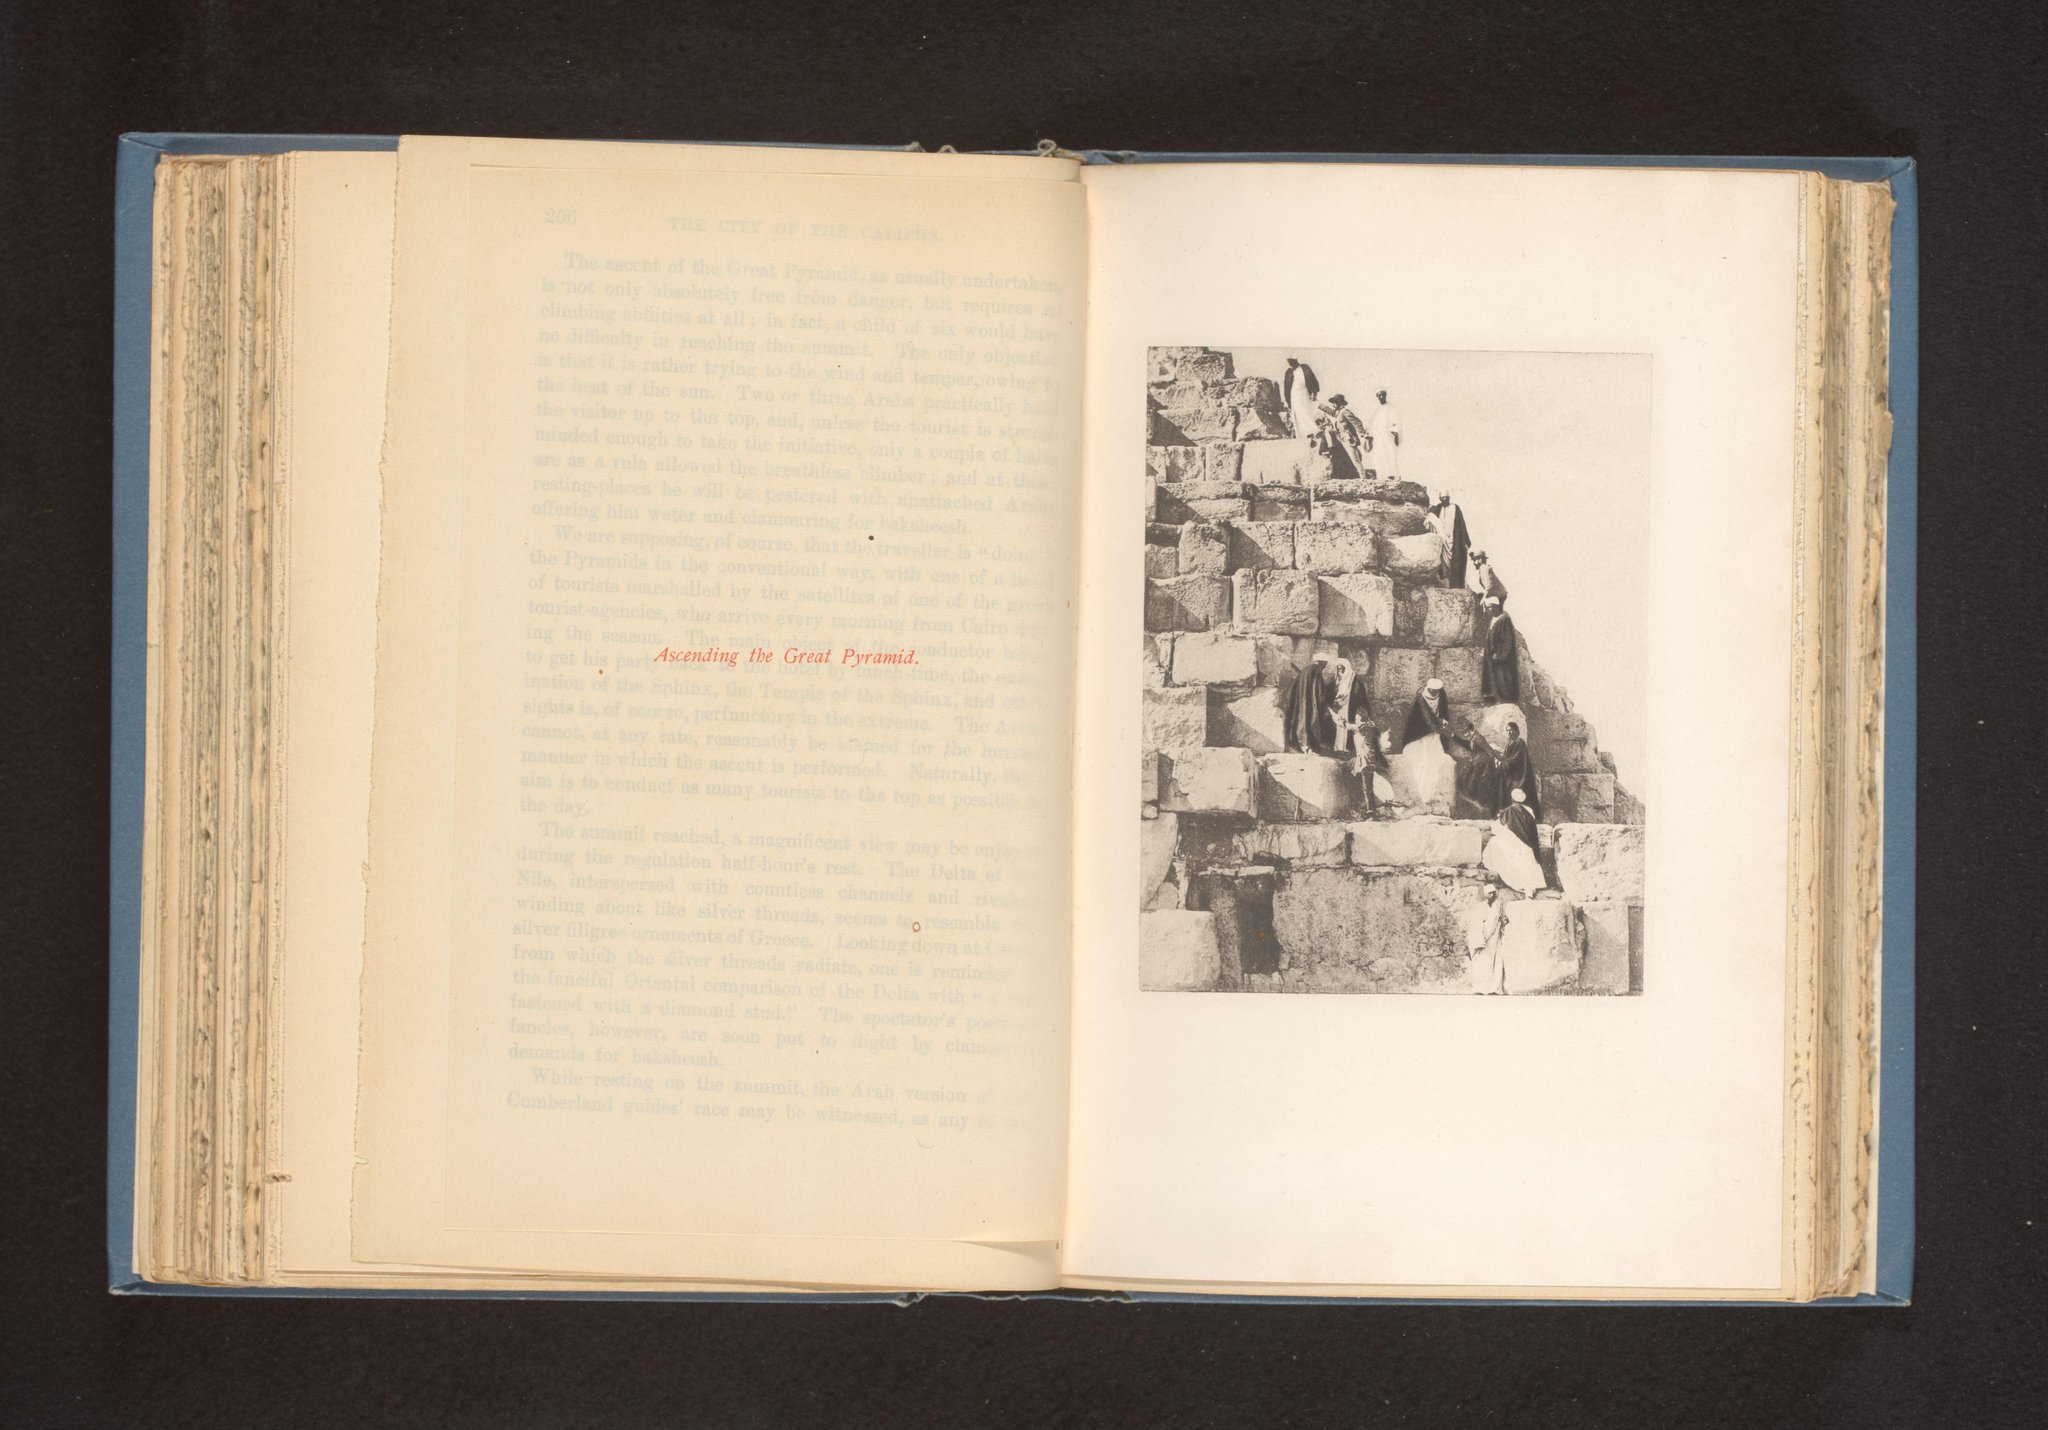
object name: page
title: Mannen beklimmen de Piramide van Cheops te Gizeh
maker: Anonymous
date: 1887-1897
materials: paper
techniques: photoaquatint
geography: gizeh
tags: climbing, egyptian pyramids (wonder of the world)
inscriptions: title: ‘Ascending the Great Pyramid’